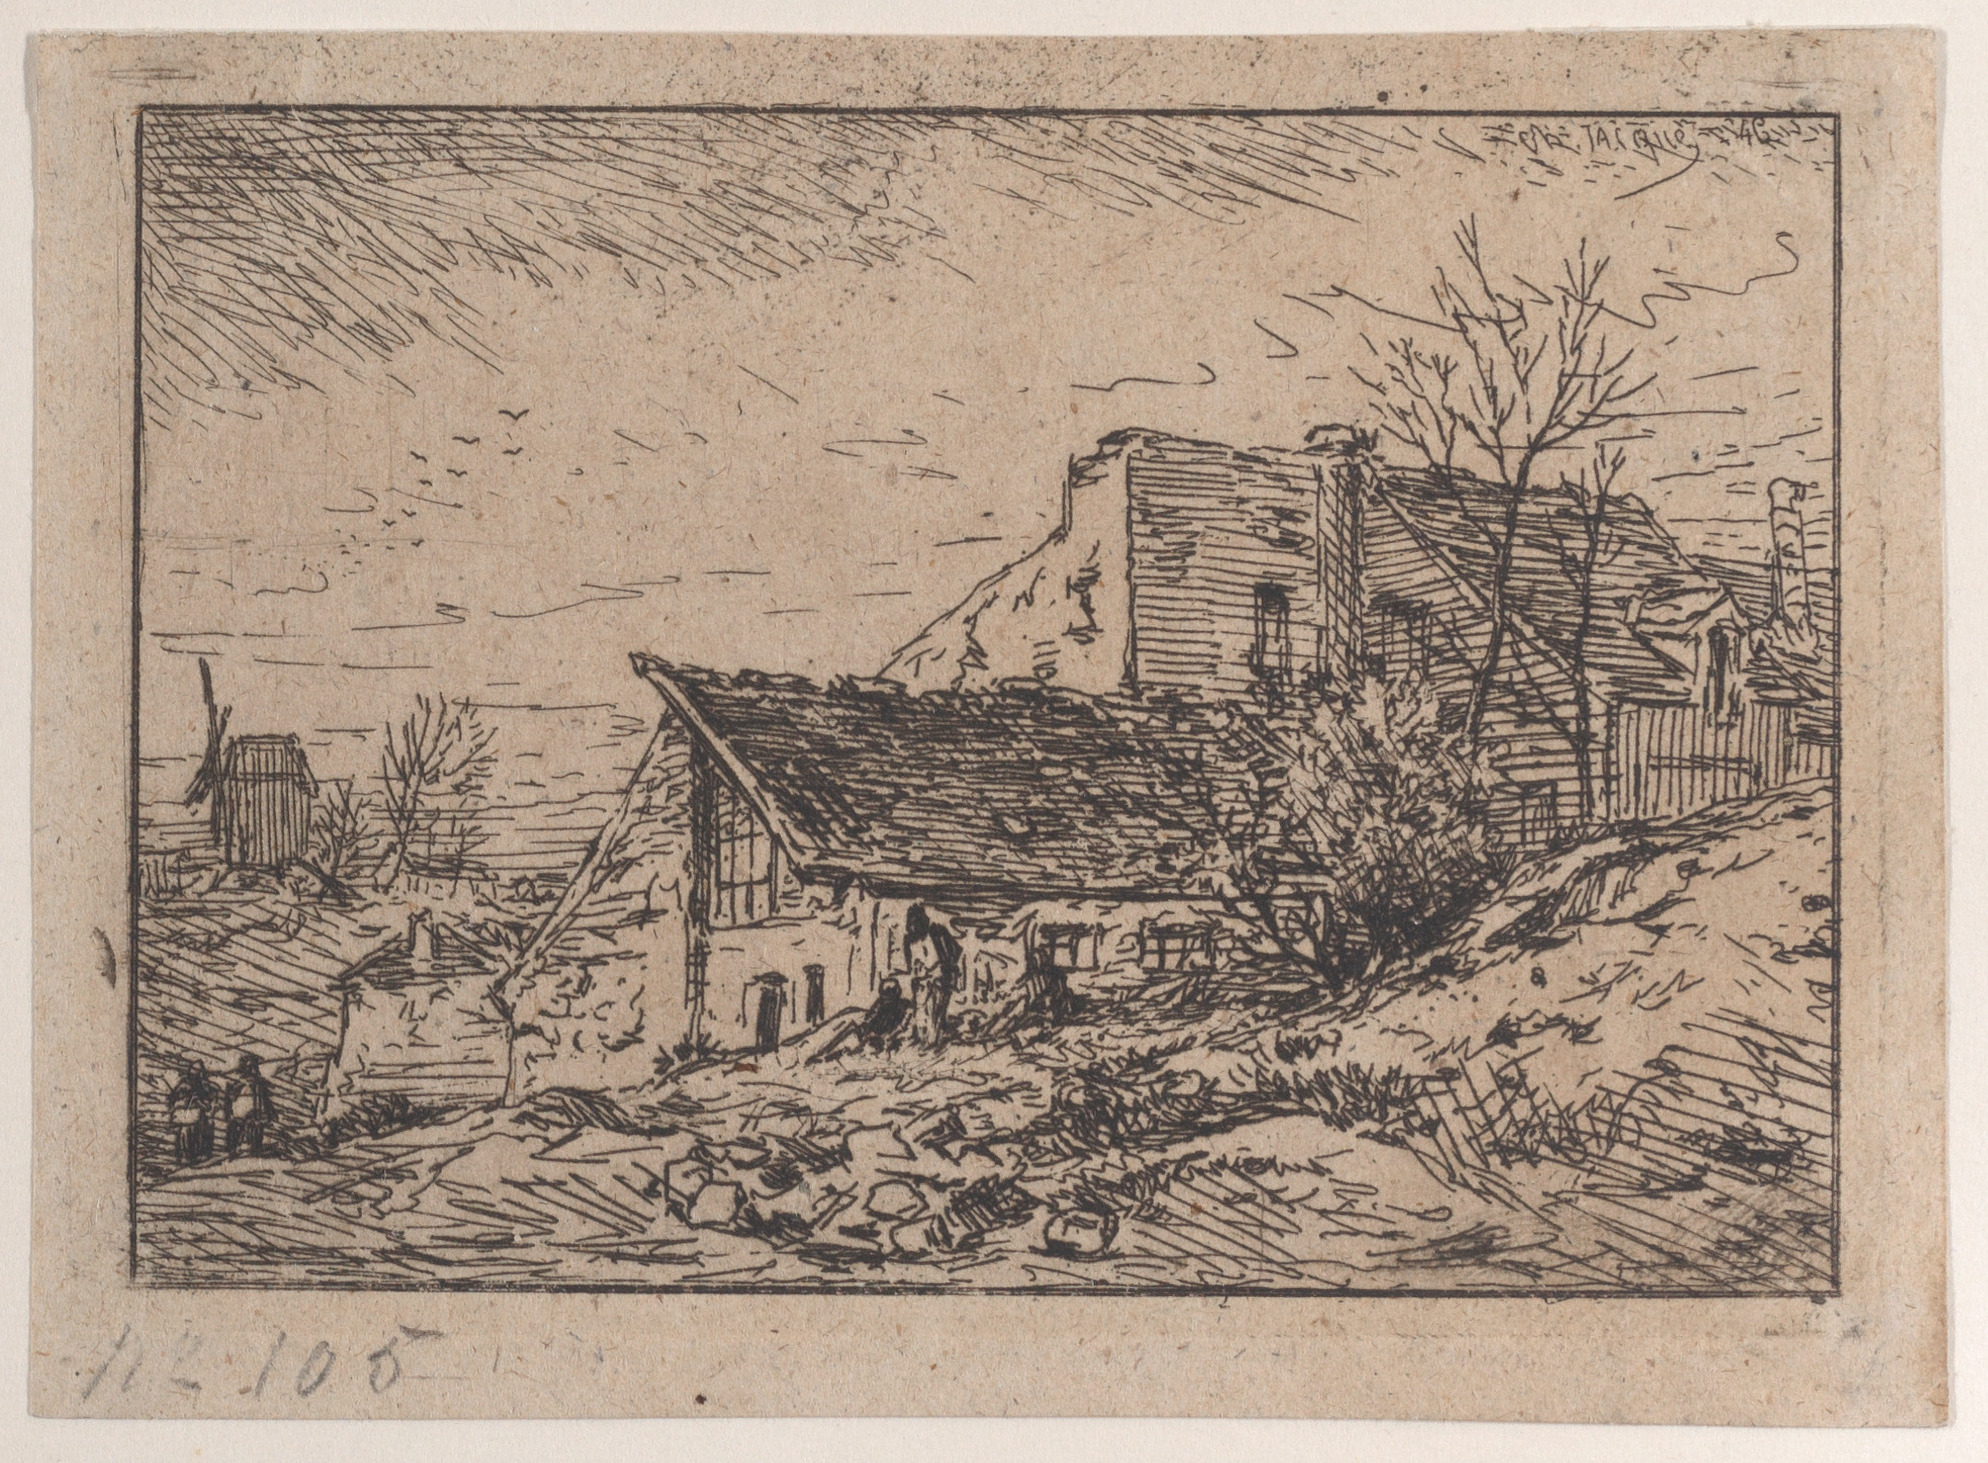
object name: print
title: Landscape with Hovels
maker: charles émile jacque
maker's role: artist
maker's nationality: french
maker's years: 1813-1894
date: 1846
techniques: etching